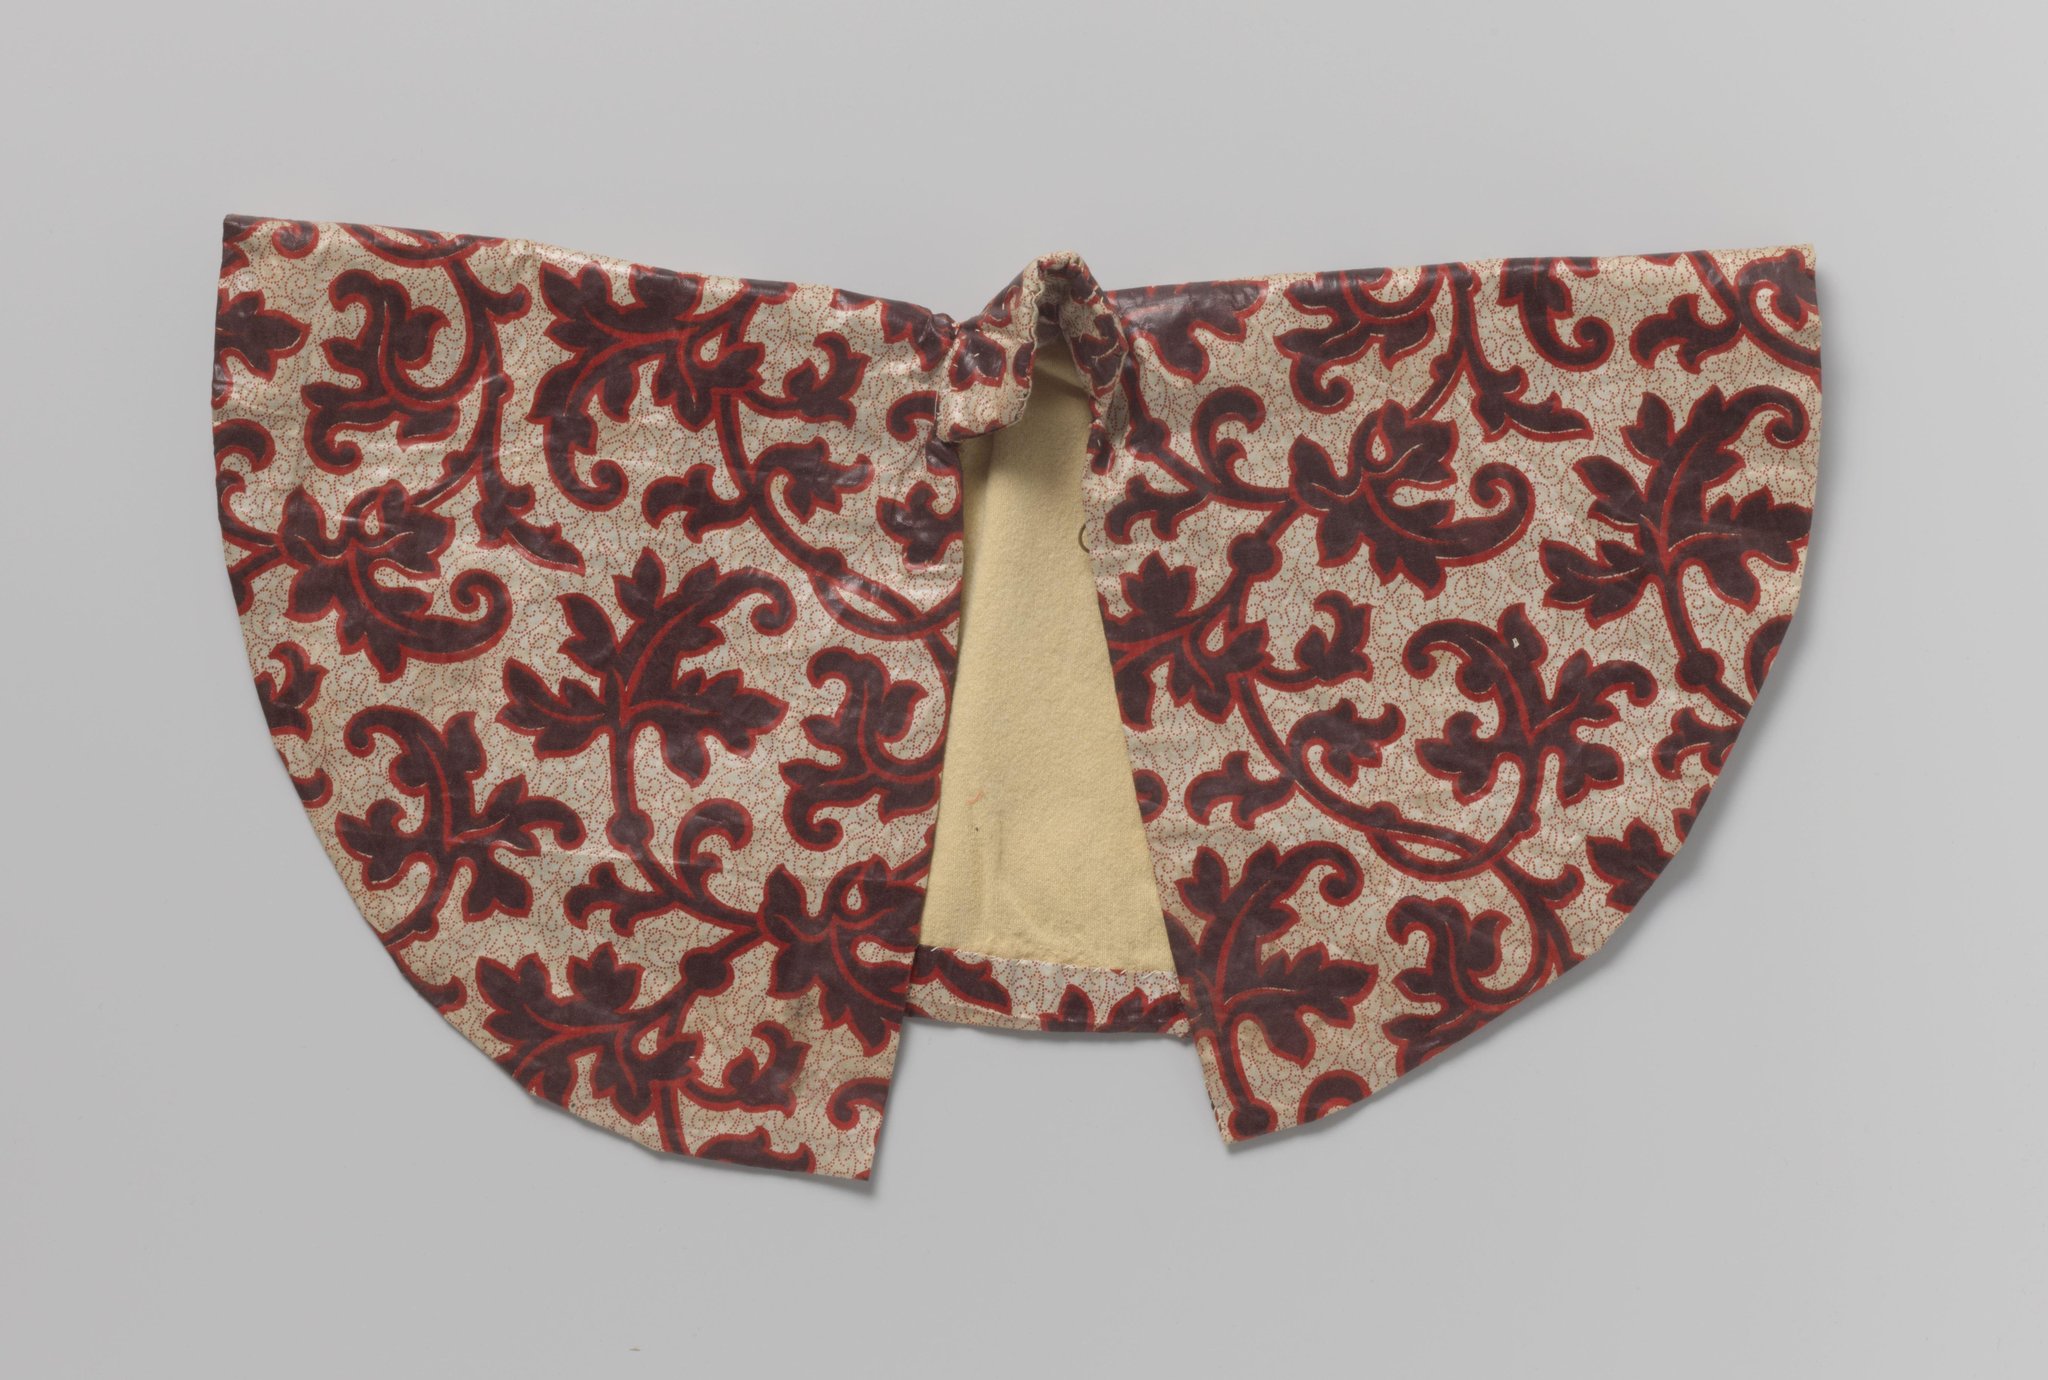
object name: jak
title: Poppenjak van sits, met een wit fond met rood omrande blauwe bladeren, met een ronde hals, v-vormige pas, geplooid schootje en lange mouwen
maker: Anonymous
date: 1725-1775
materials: copper, cotton, paint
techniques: painting, weave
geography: amsterdam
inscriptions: date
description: Poppenjak van sits, met een wit fond met rood omrande blauwe bladeren, met een ronde hals, v-vormige pas, geplooid schootje en lange mouwen. Sluiting middenachter met koperen haak en oog. Smalle ceintuur vanaf de zijnaden over de achterpanden.